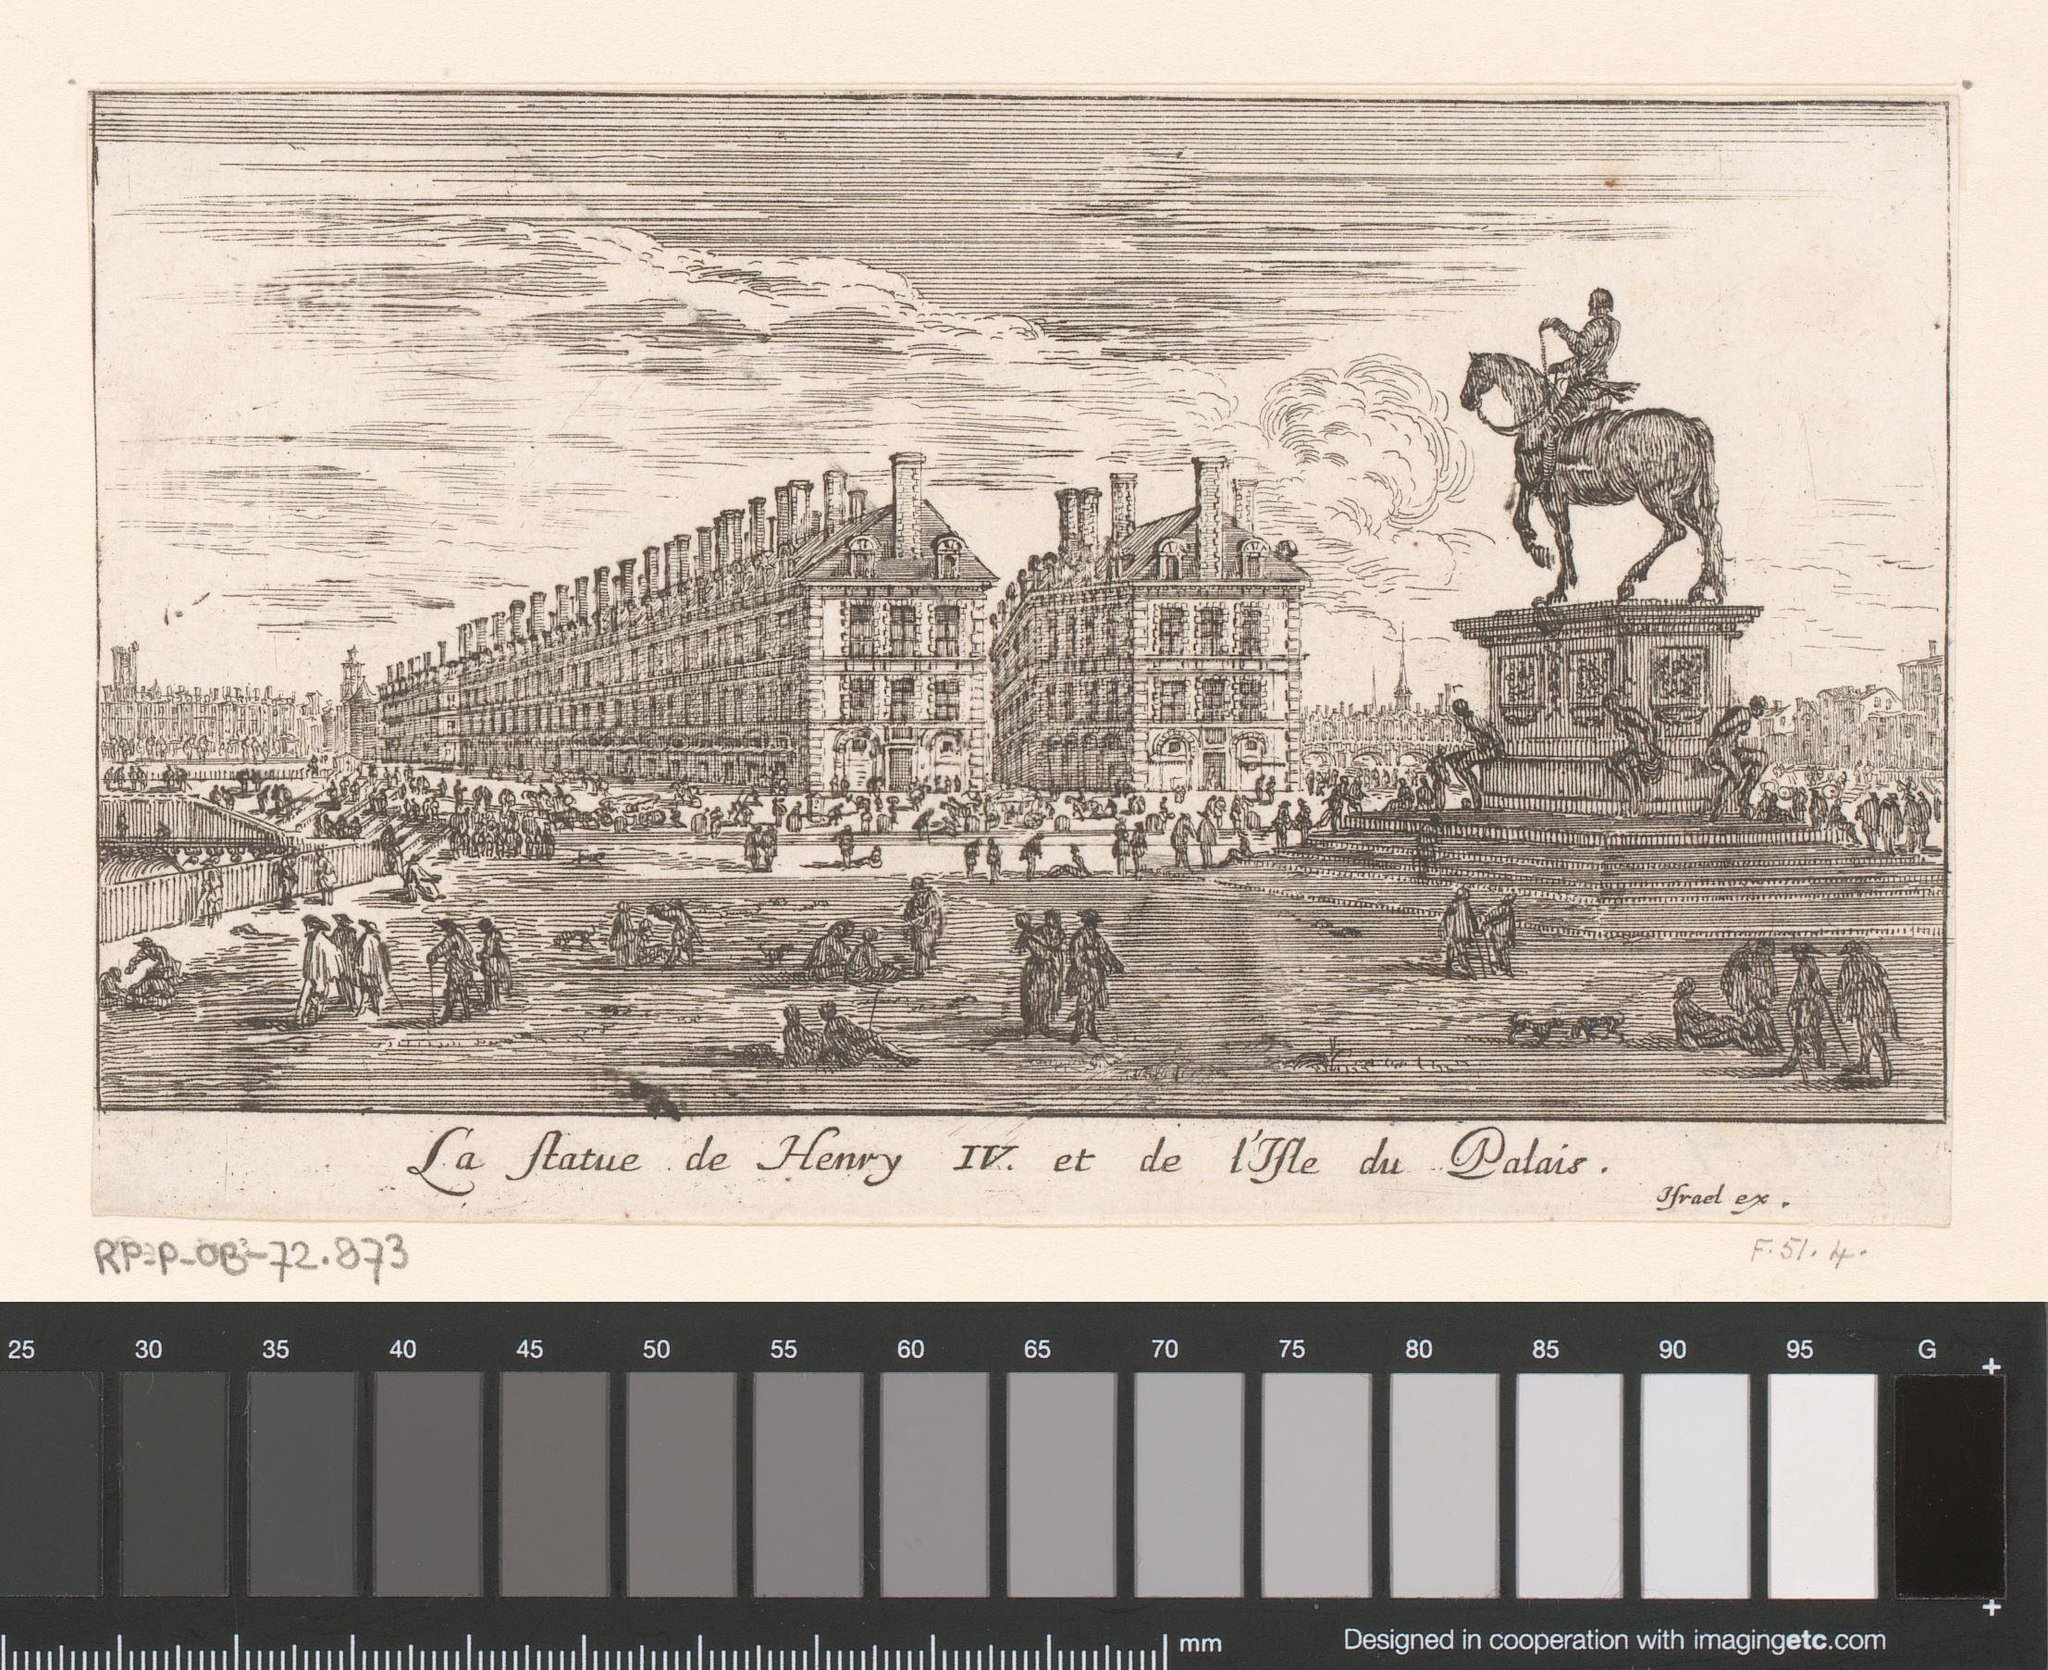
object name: print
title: Gezicht op het standbeeld van Hendrik IV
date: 1652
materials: paper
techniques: etching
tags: monument, statue, equestrian statue, paris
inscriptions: collector's mark: Lugt 240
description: Prent maakt deel uit van een ongenummerde serie van twintig prenten.